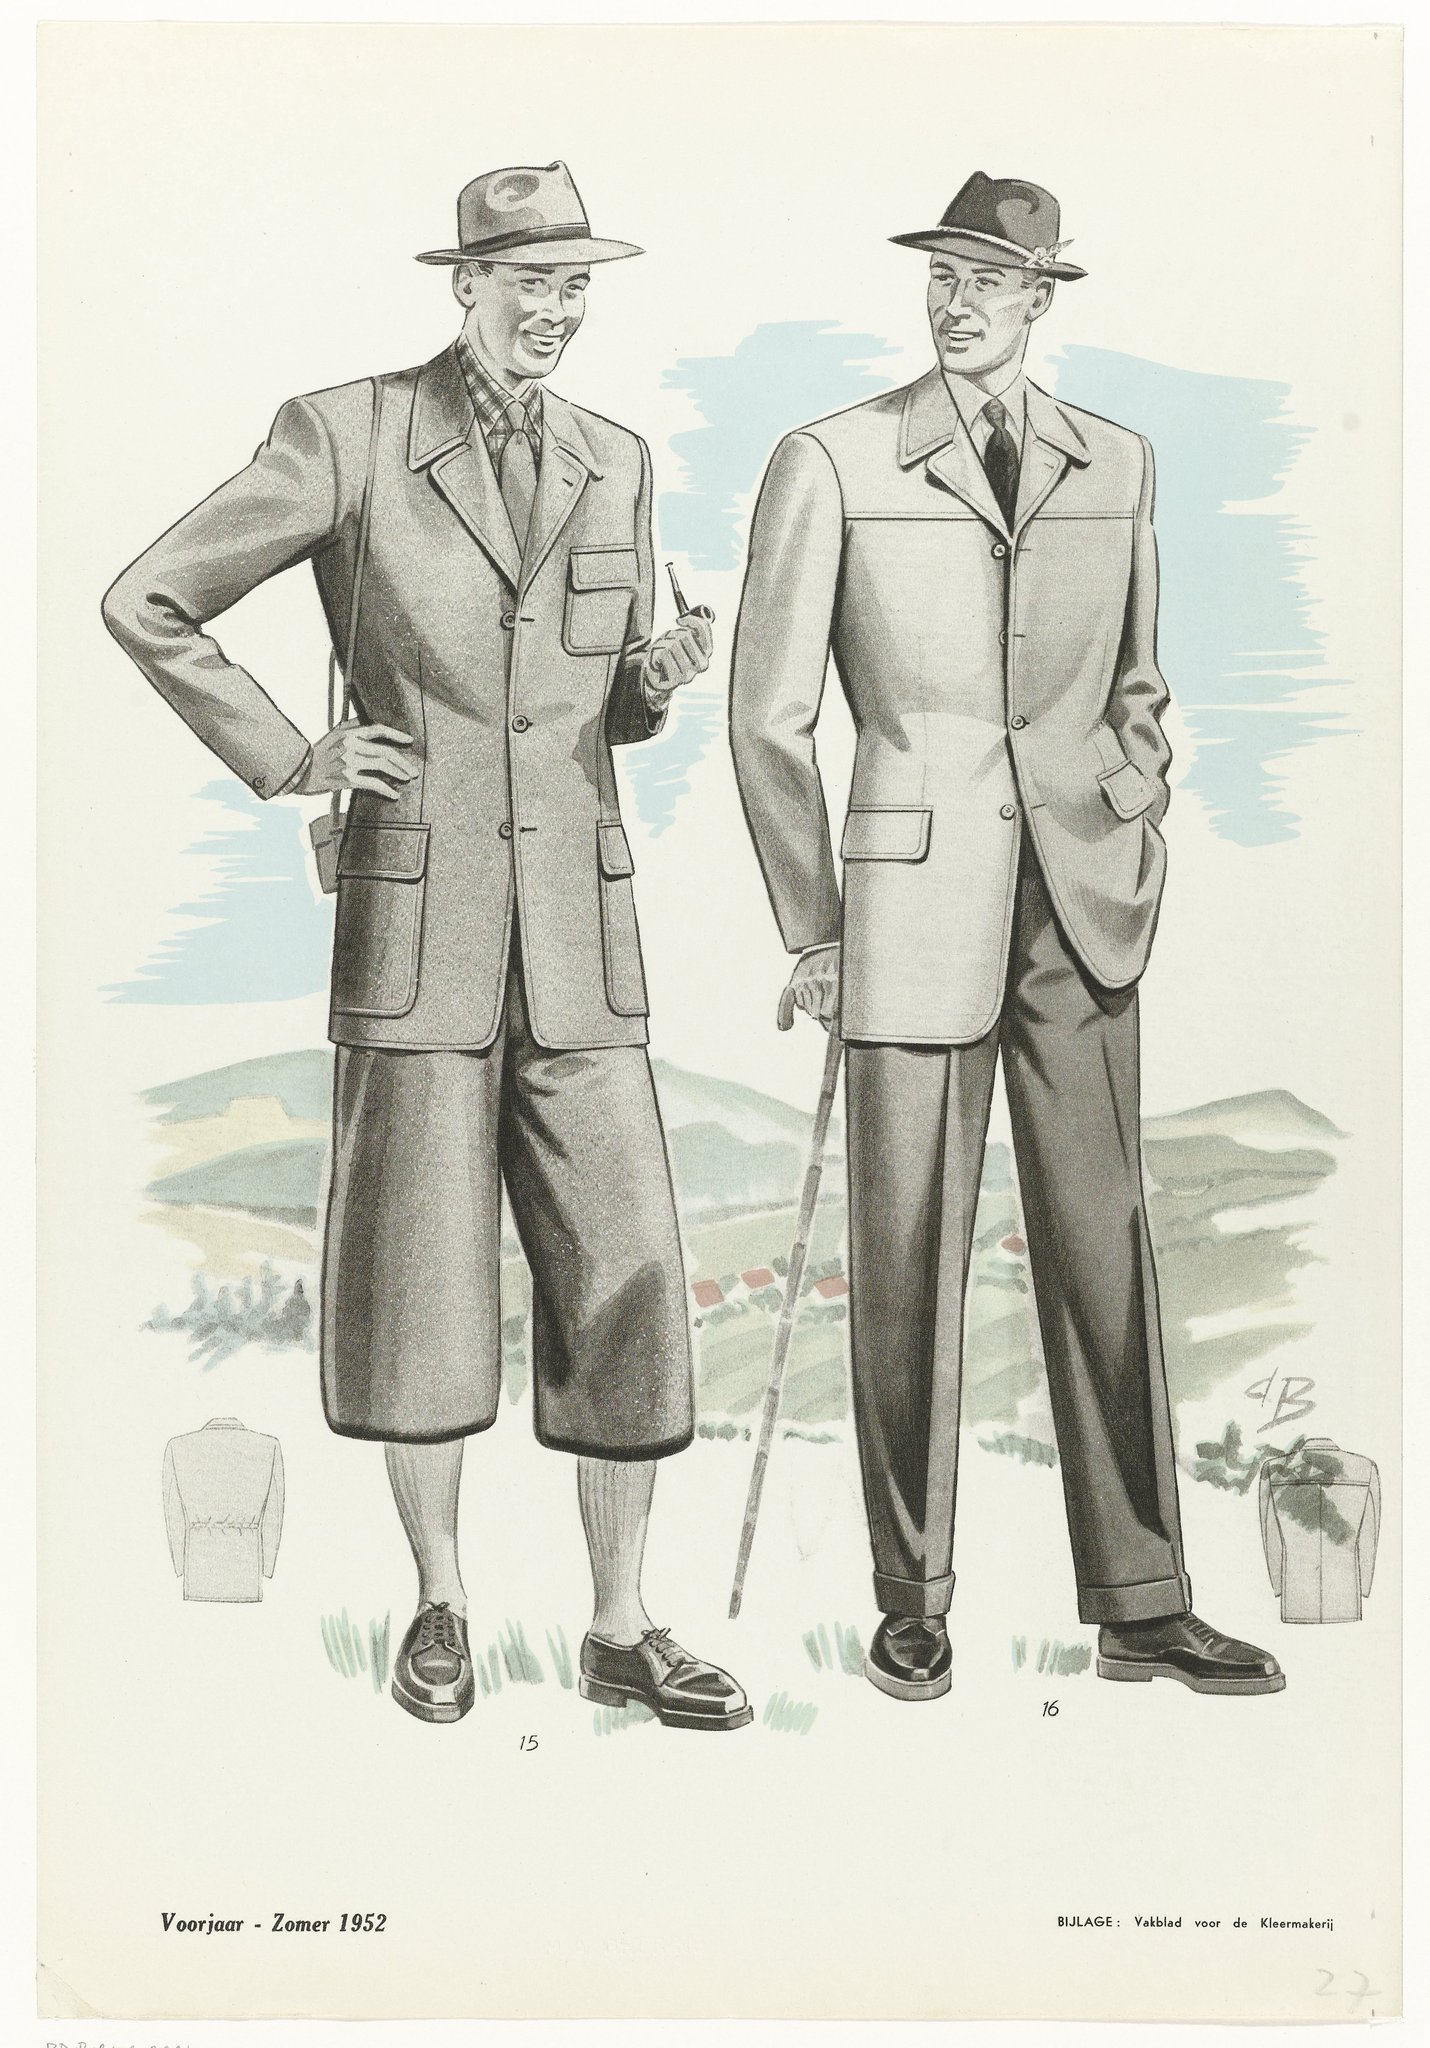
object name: fashion print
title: Vakblad voor de kleermakerij, Voorjaar-Zomer 1952, Nr. 15 en Nr. 16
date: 1952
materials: paper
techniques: printing, photochemical processes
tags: neck-gear ~ clothing (tie) (+ men's clothes), bag (+ men's clothes), trousers, breeches (+ men's clothes), coat (+ men's clothes), pipe ~ tobacco, head-gear: hat (+ men's clothes), fashion plates, shoes, sandals (+ men's clothes), trousers, breeches, etc. (breeches) (+ men's clothes), gloves, mittens, etc. (+ men's clothes), walking-stick, staff, cane (+ men's clothes)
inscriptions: caption: ‘Voorjaar - Zomer 1952’, title: ‘Bijlage: Vakblad voor de kleermakerij’